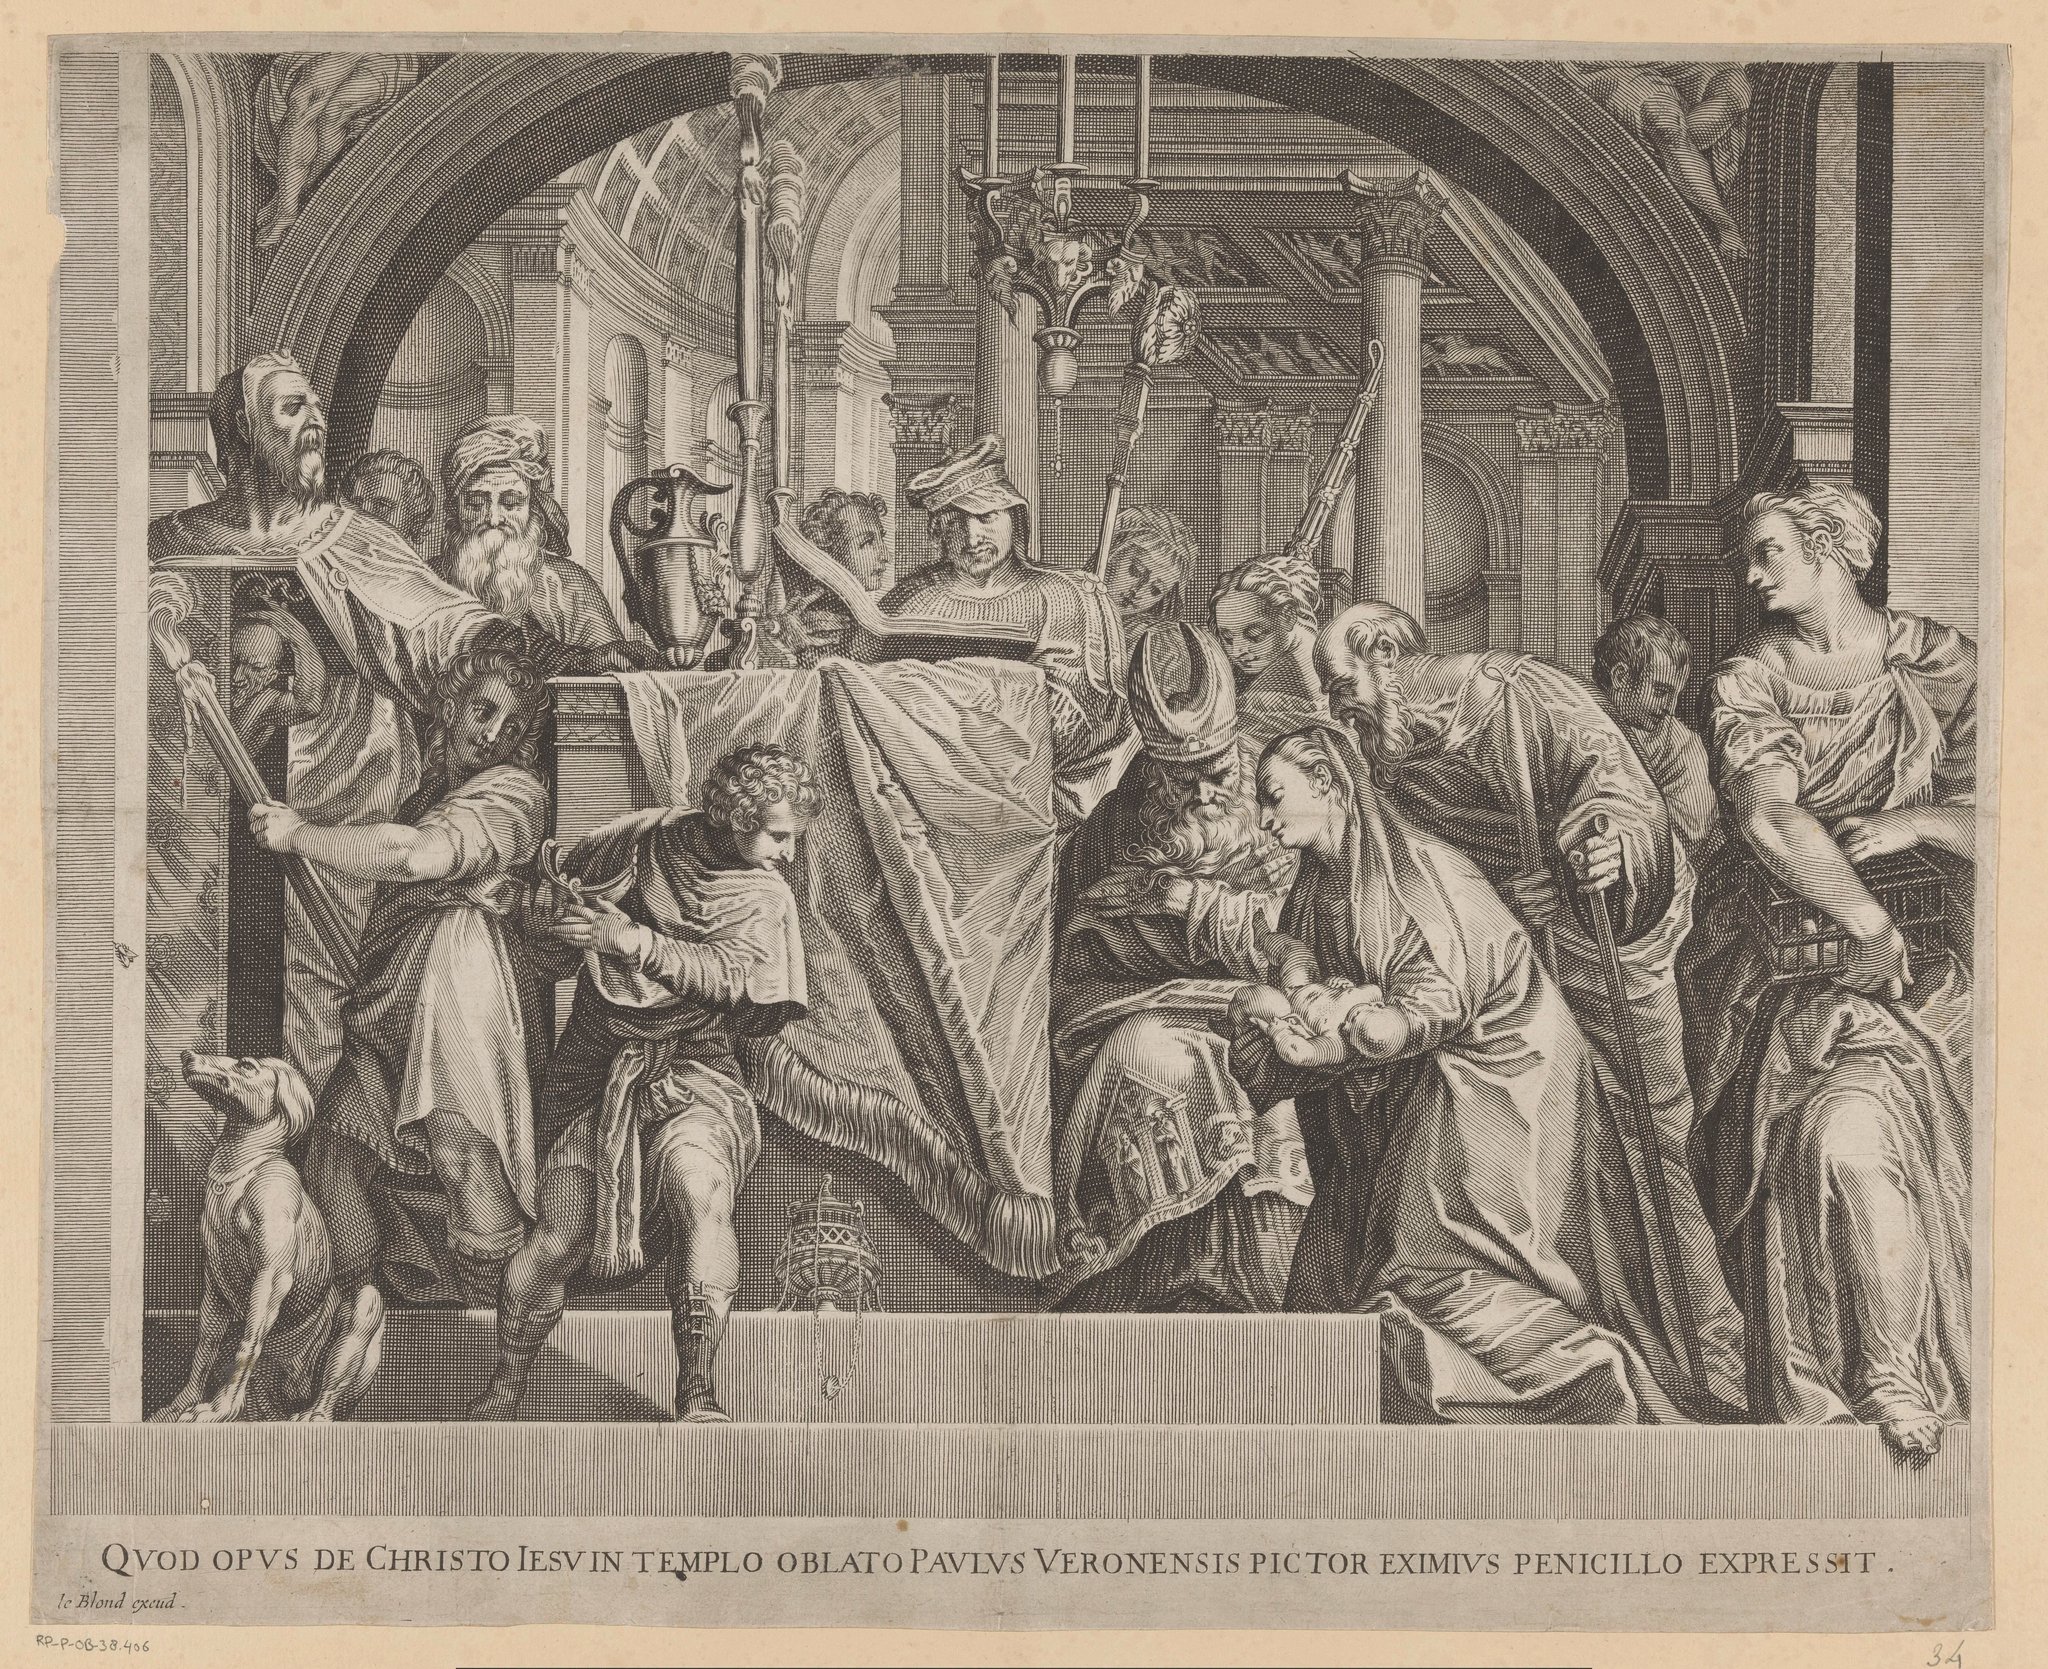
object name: print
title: Presentatie van Christus in de tempel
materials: paper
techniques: engraving, intaglio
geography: italy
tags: presentation of the christ-child in the temple, usually simeon (and anna) present (luke 2:22-39)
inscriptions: collector's mark: Lugt 240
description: Maria zit geknield met het Christuskind in de armen. Naast haar de hogepriester Simeon. Rechts een vrouw met een kooi met duiven. Een regel Latijnse tekst in ondermarge.